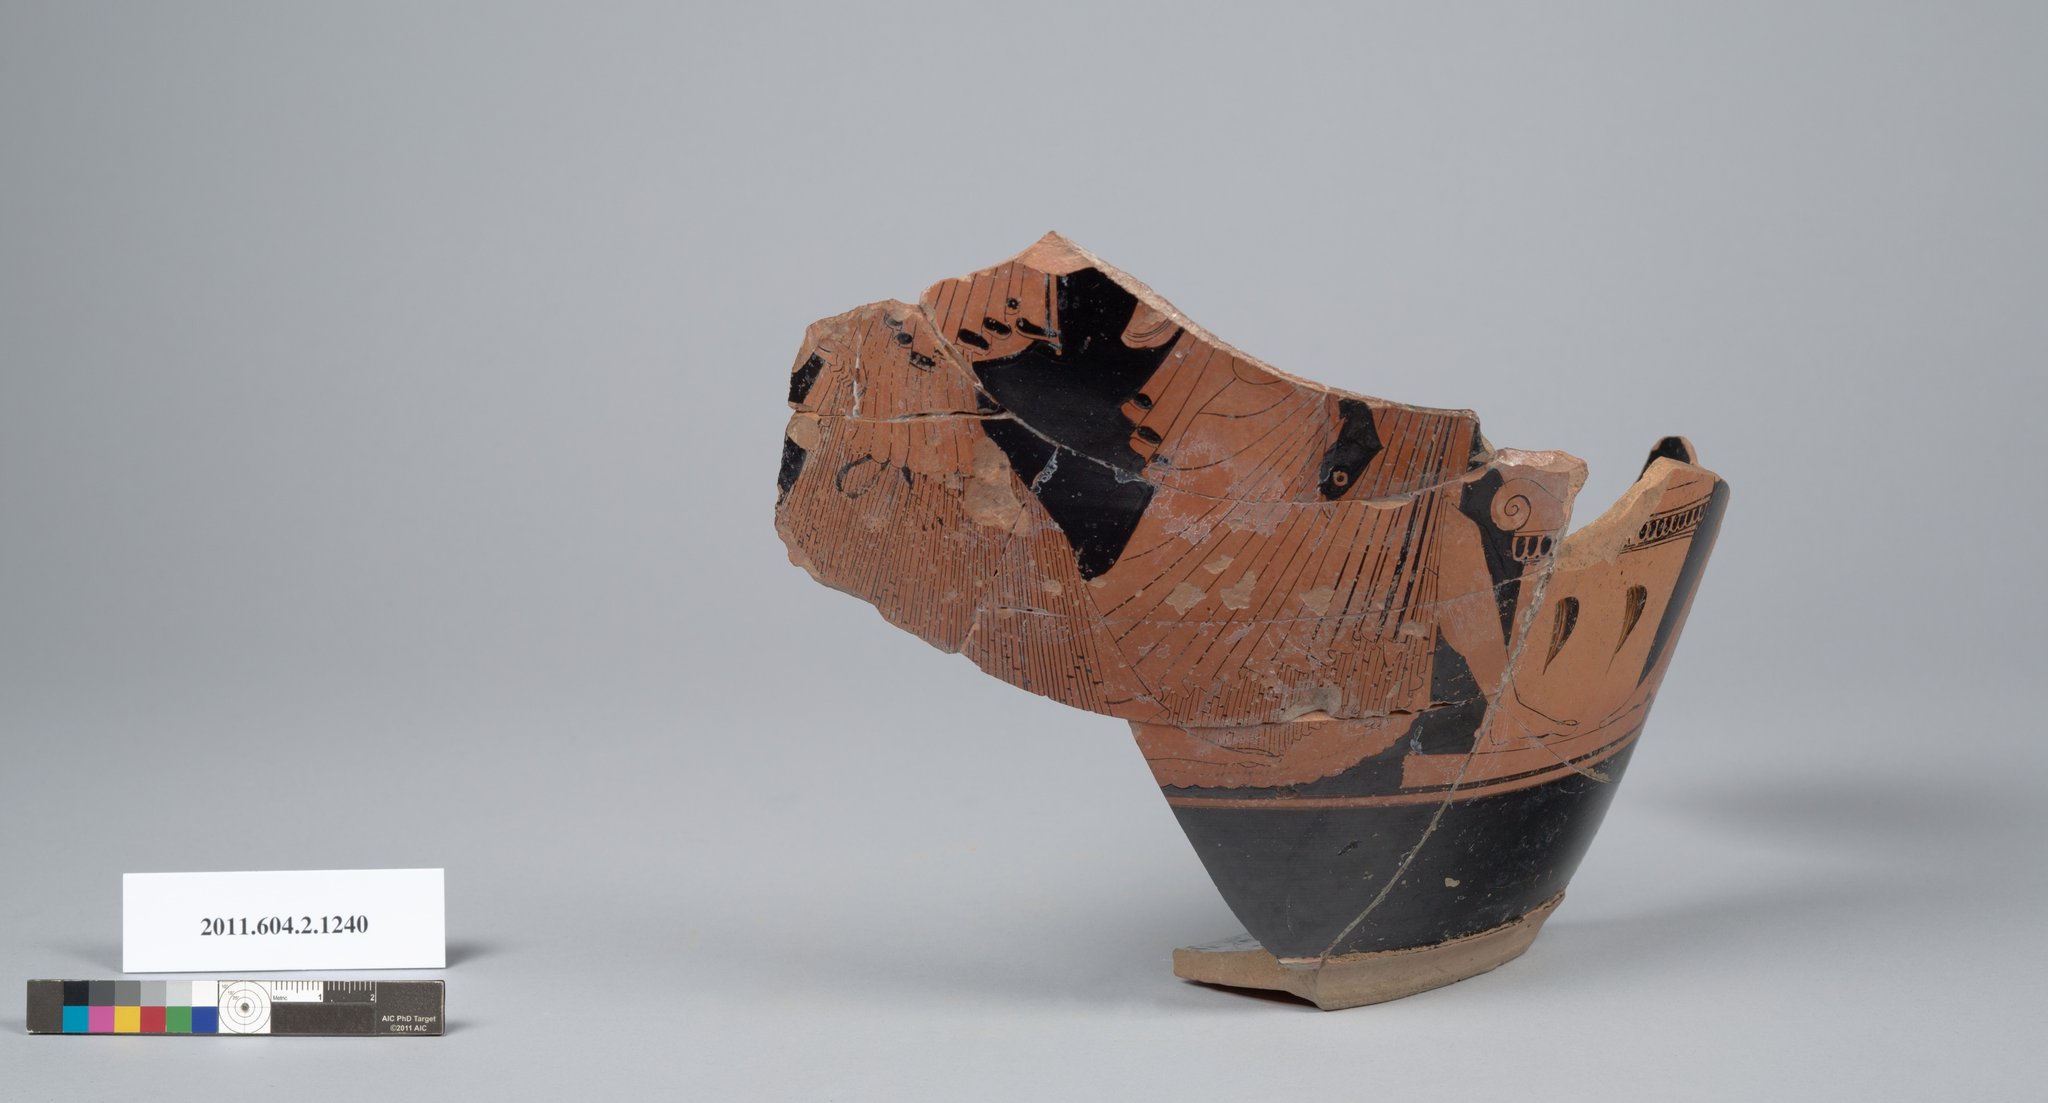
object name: skyphos fragment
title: Terracotta fragment of a skyphos (deep drinking cup)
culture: greek, attic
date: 490-480 BCE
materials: terracotta